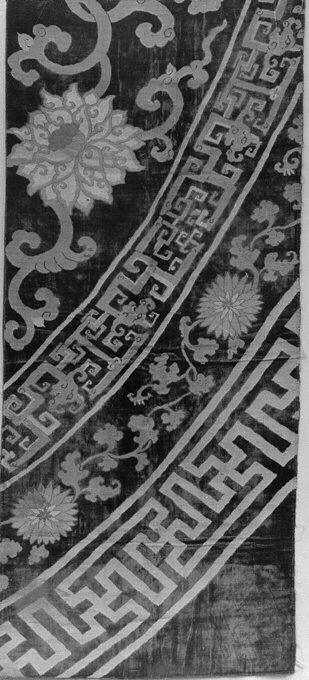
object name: panel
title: Velvet Panel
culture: chinese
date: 1662-1722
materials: silk, velvet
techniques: cutting, voiding